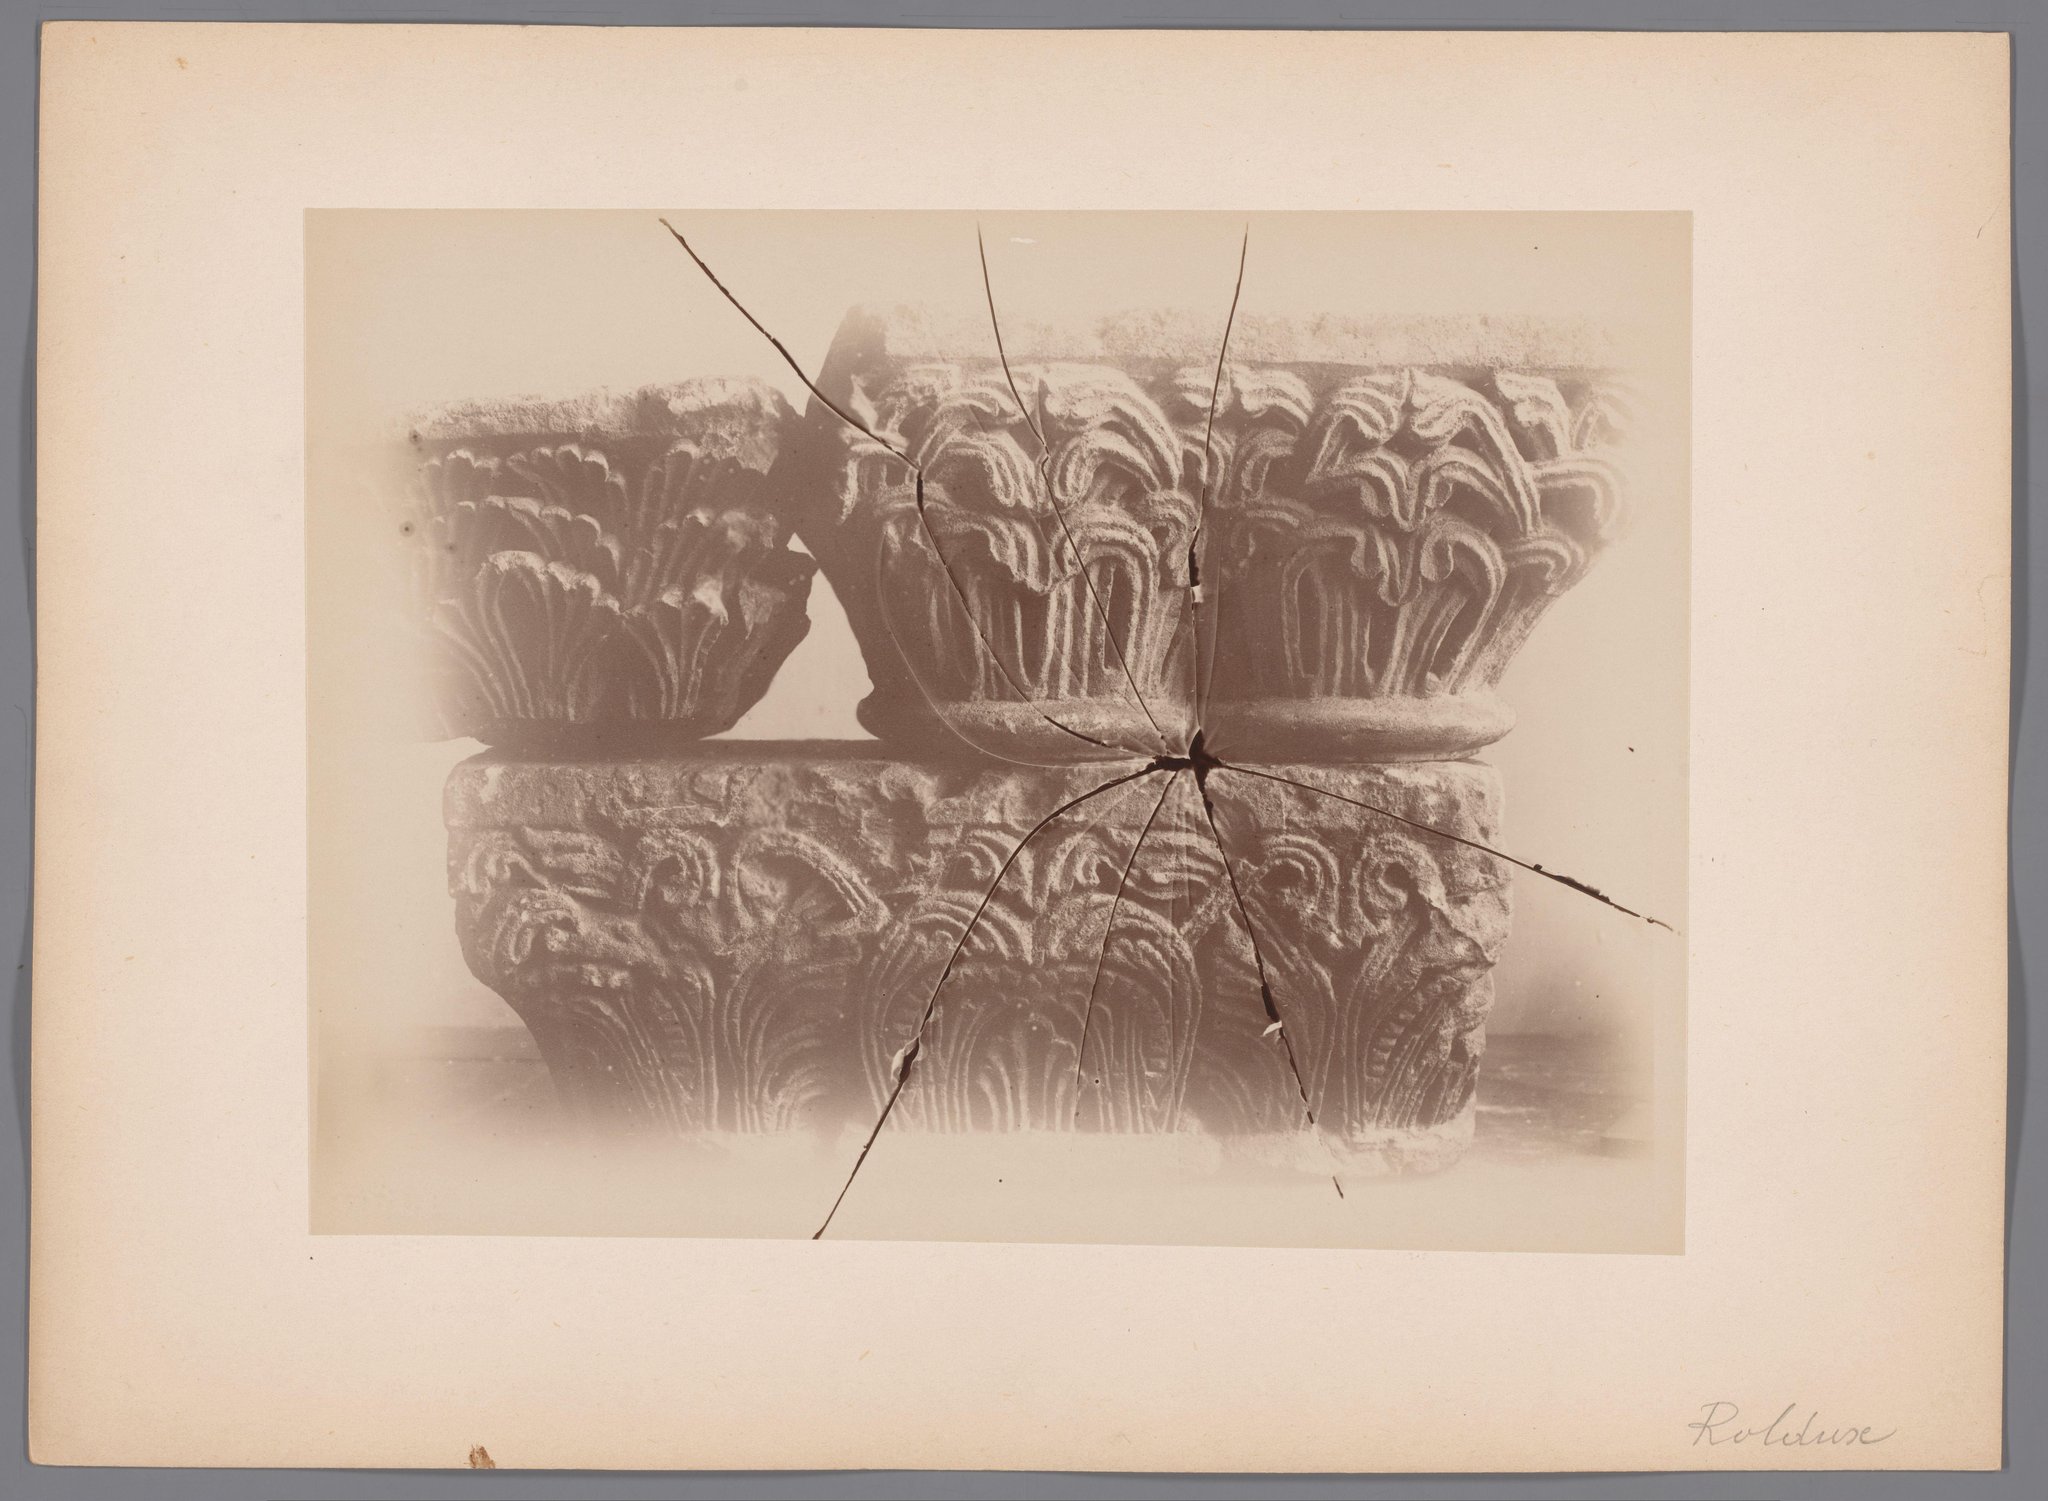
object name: photograph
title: Kapitelen, gevonden bij opgravingen op de binnenplaats van het seminarie te Rolduc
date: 1890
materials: cardboard, photographic support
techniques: albumen print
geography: rolduc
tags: capital (~ column, pillar)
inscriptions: annotation: ‘Kapiteelen gevonden bij het doen van / opgravingen op de binnenplaats van het / Instituut te Rolduc oct 1890’, annotation: ‘Rolduc’